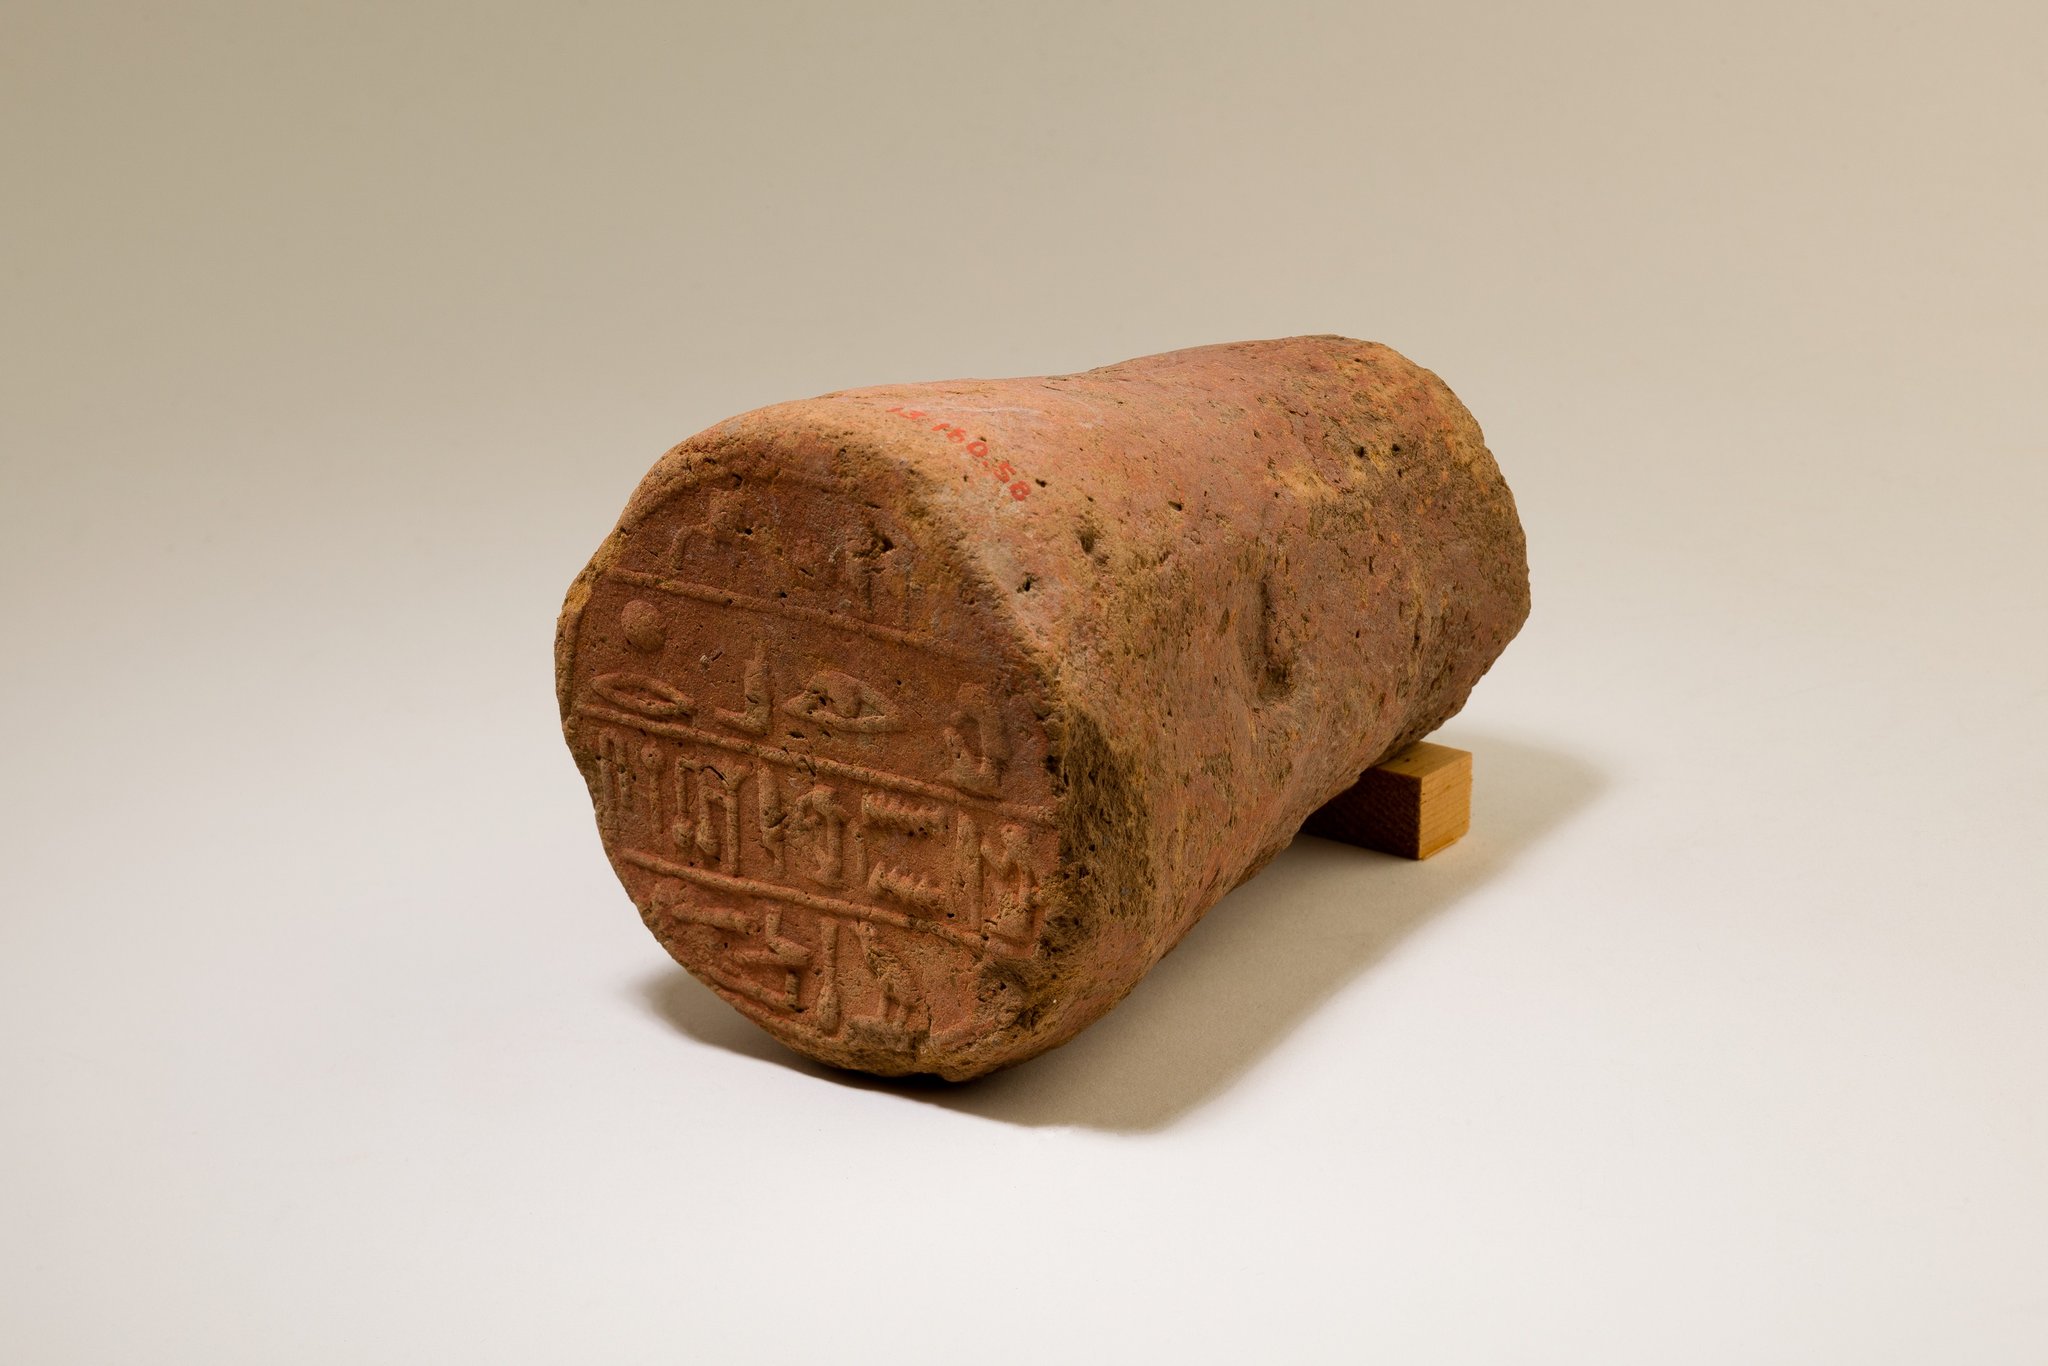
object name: cone, curcular impression, ineni, inspector of scribe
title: Funerary Cone of the Overseer of Scribes Ineni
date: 1550-1295 BCE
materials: pottery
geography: egypt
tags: hieroglyphs